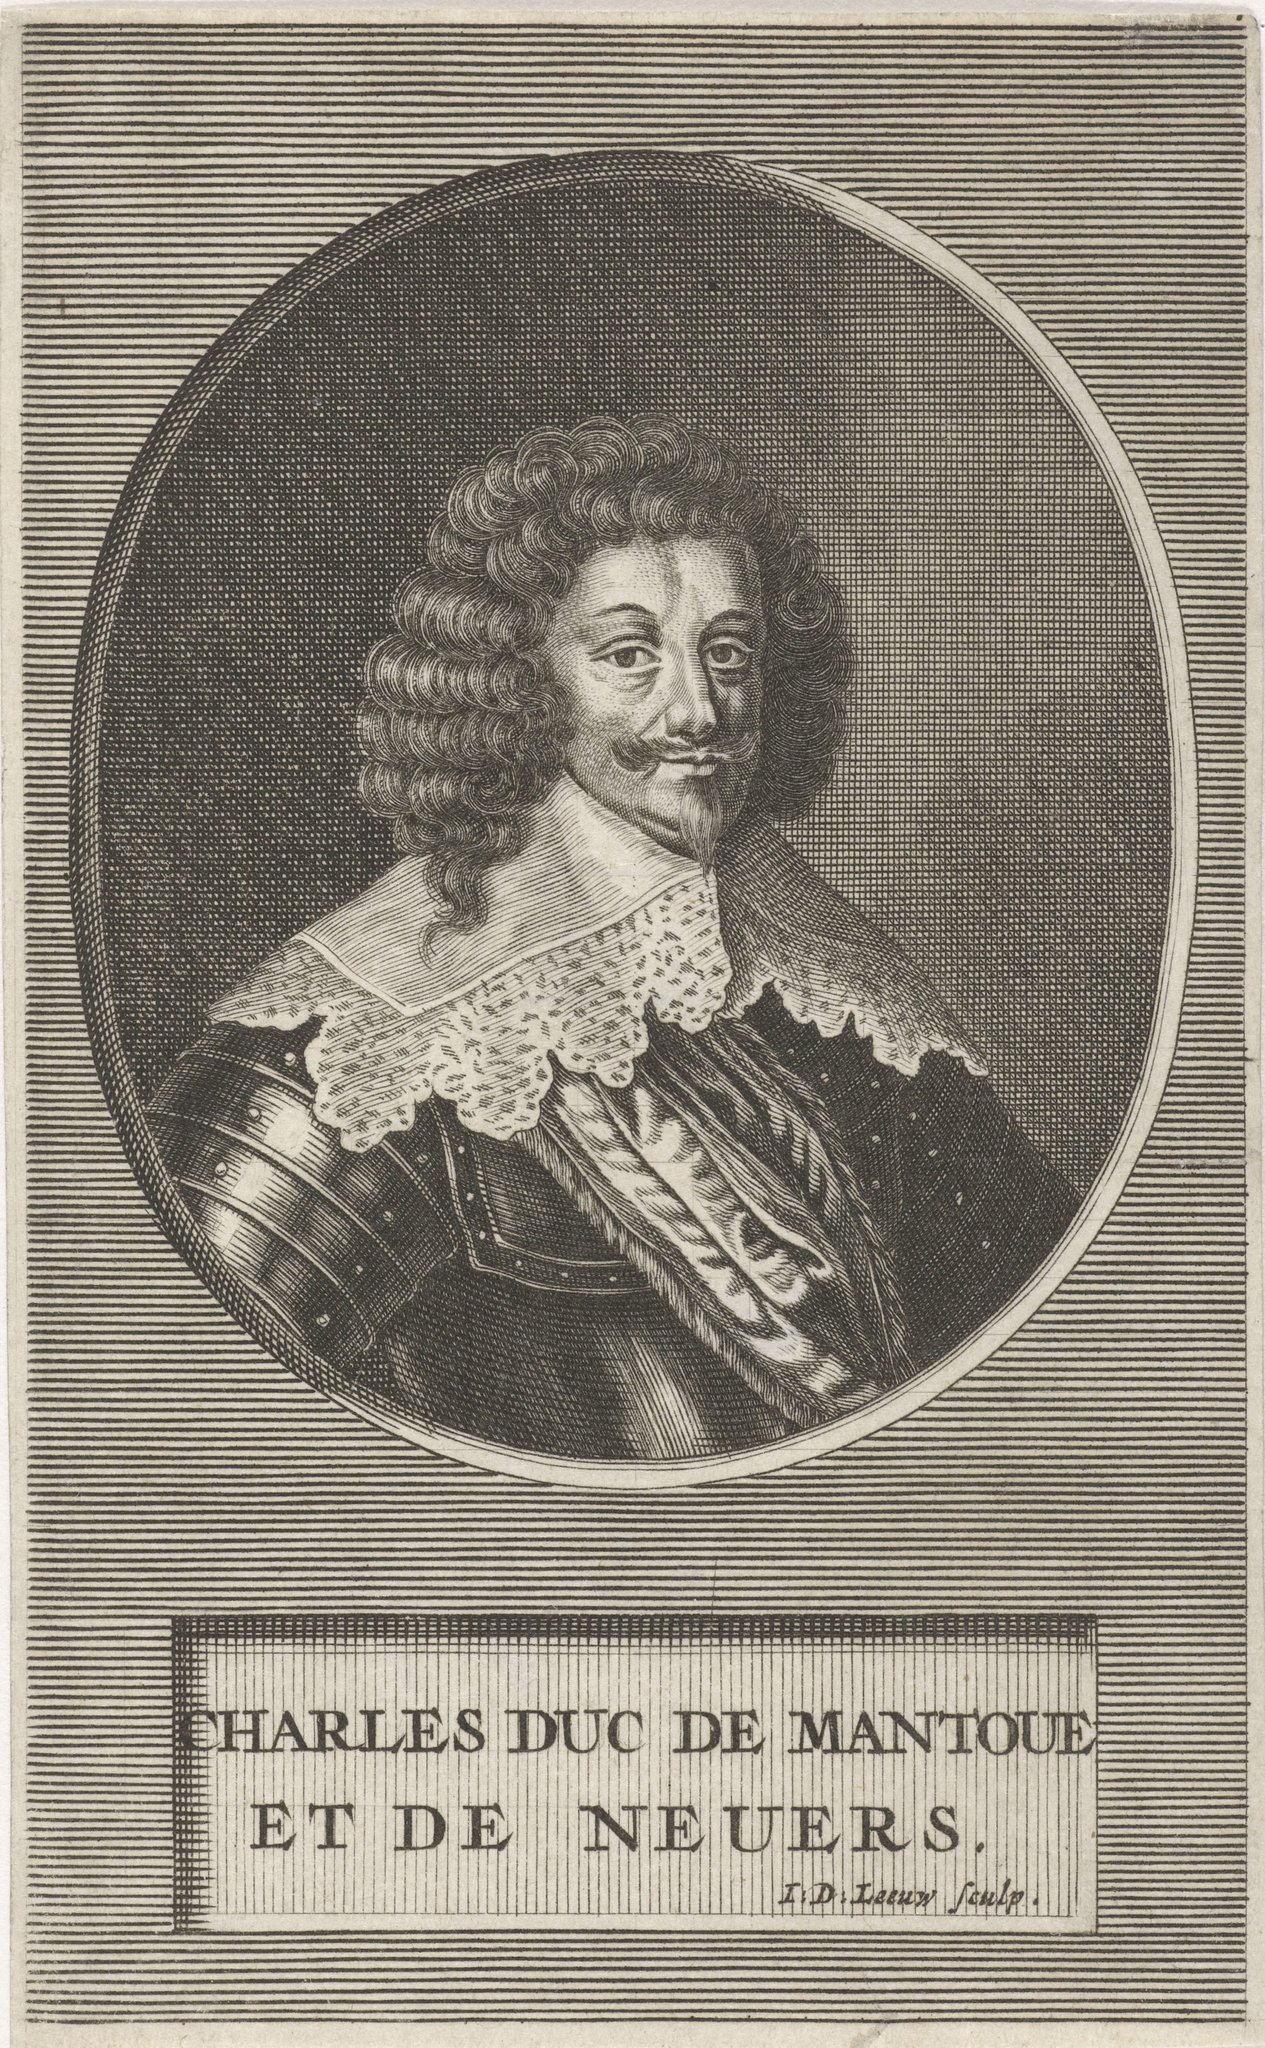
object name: print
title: Portret van Charles, hertog van Mantoue en Nevers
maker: jan de leeuw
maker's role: print maker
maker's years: 1660-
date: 1704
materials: paper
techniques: engraving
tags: charles (hertog van mantoue en nevers)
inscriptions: collector's mark: Lugt 2228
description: Portretbuste in ovaal naar rechts van Charles, hertog van Mantoue en Nevers, blootshoofds en gehuld in een harnas. Onder het portret staat op een plaquette de naam van de geportretteerde.